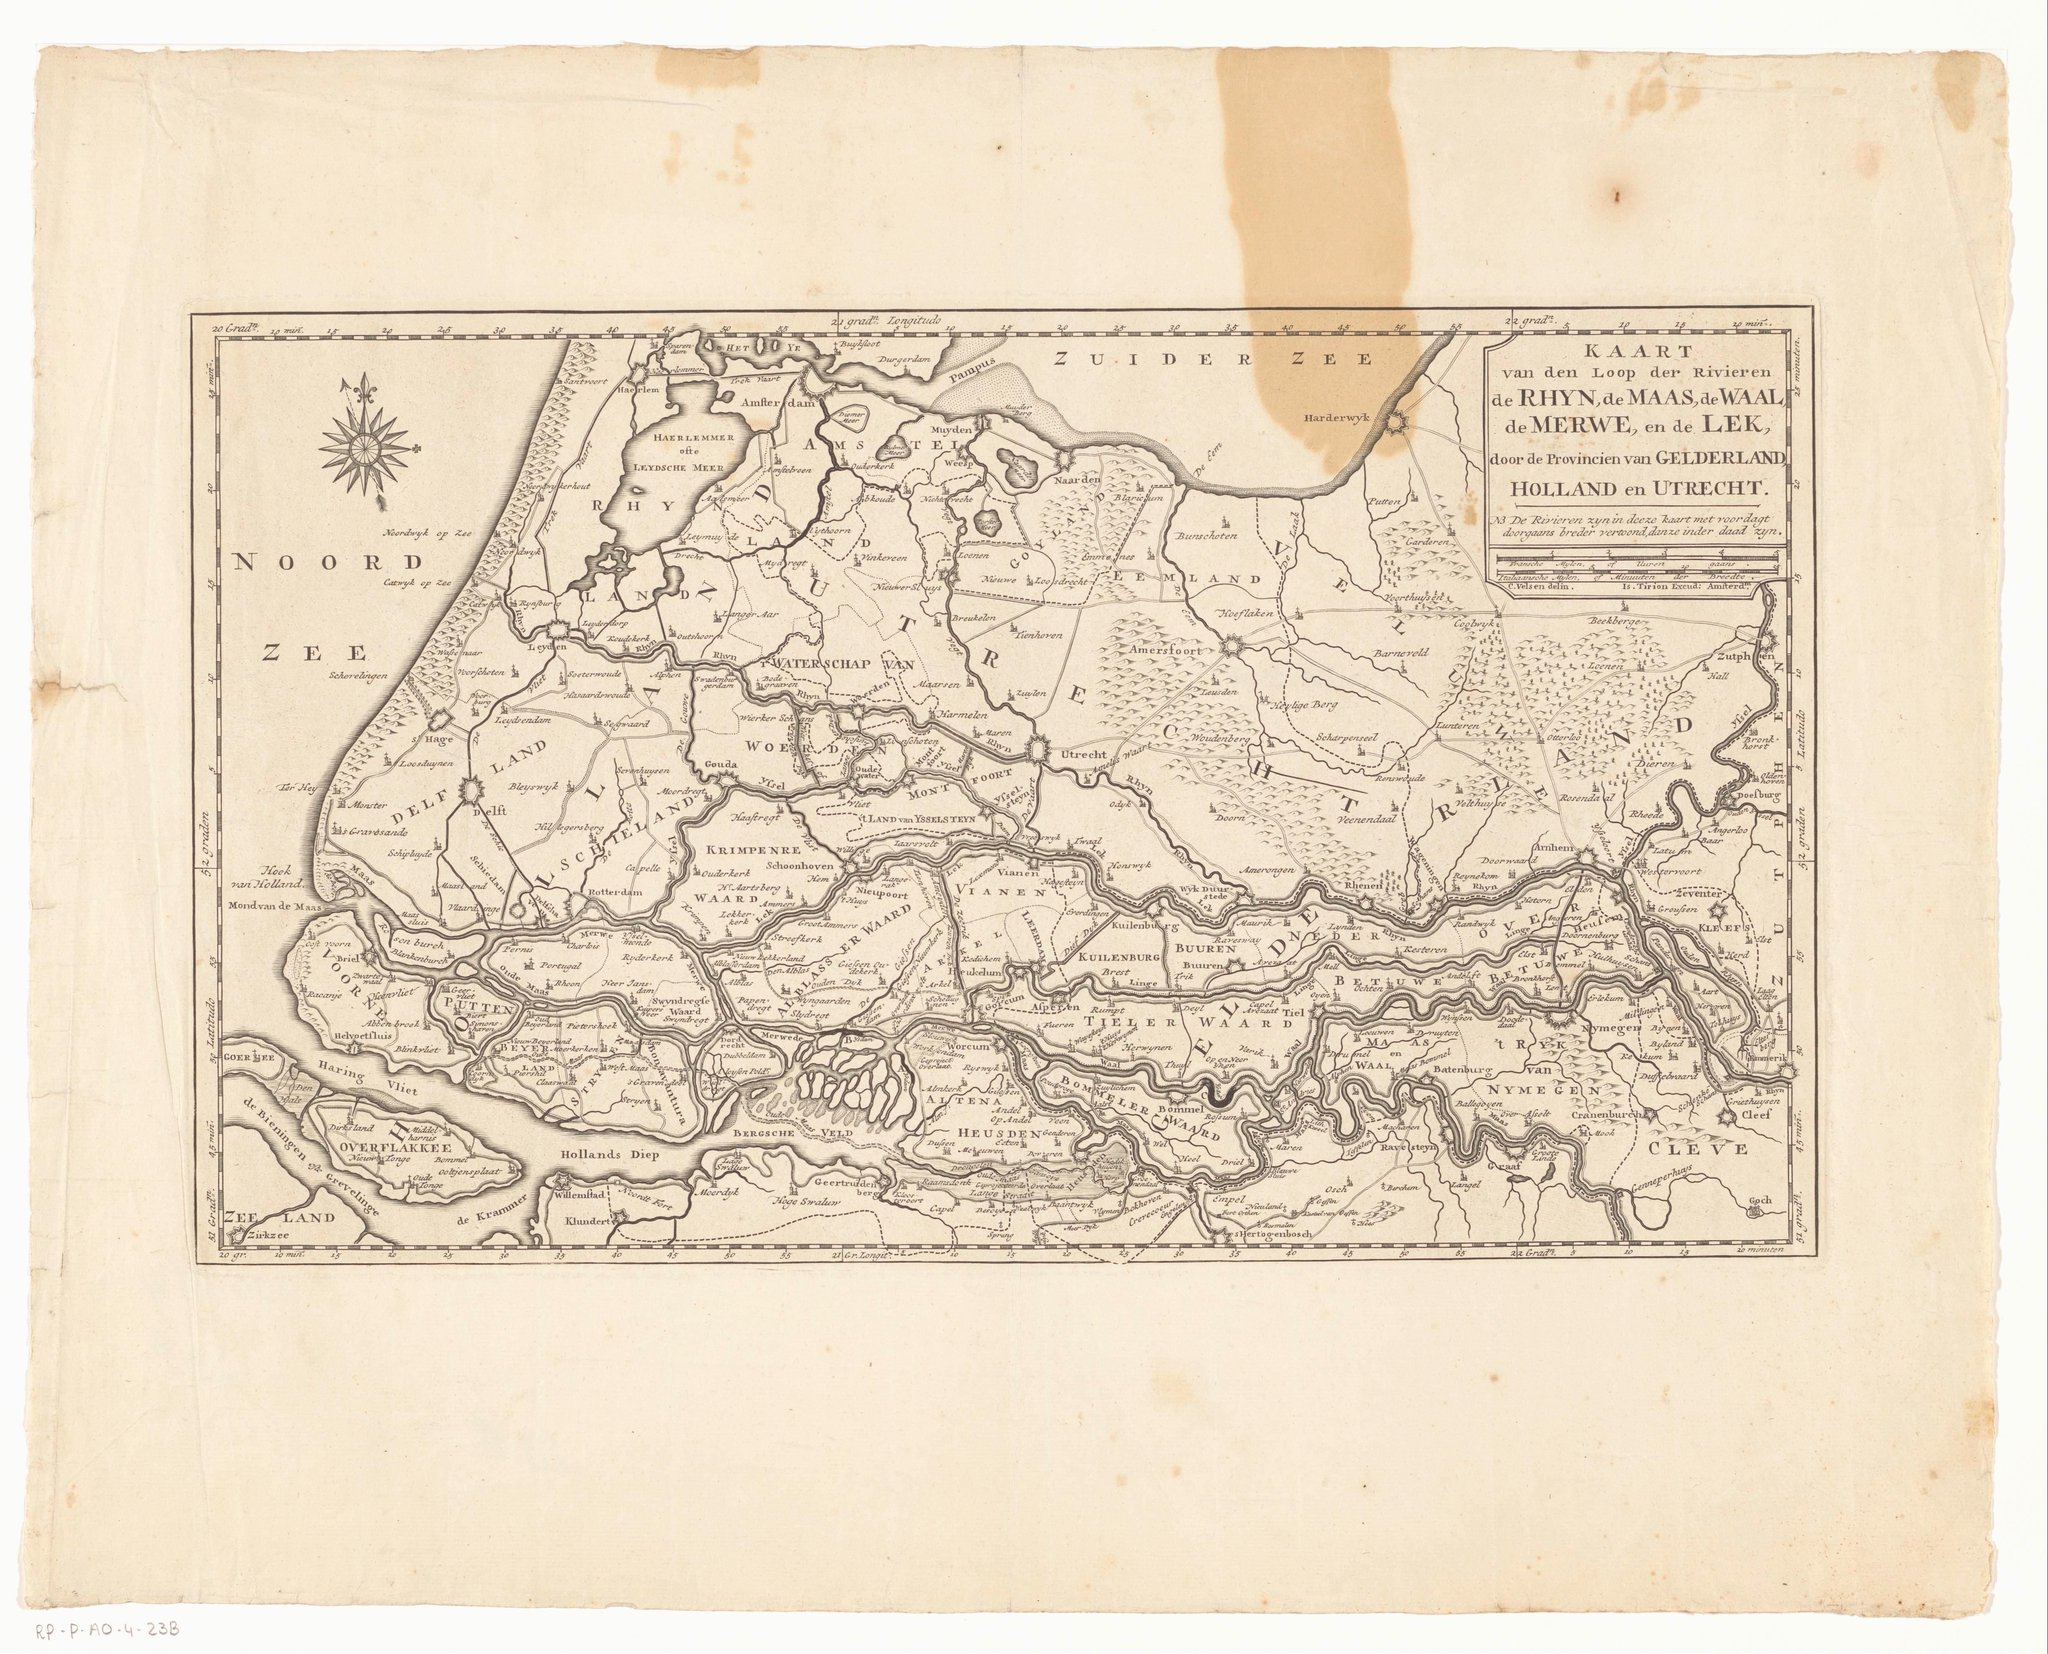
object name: print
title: Kaart van het gebied rond de Rijn, de Maas, de Merwede en de Lek in Gelderland, Holland en Utrecht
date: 1749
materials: paper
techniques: engraving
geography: amsterdam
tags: maps of separate countries or regions, gelderland, holland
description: Prent ook gebruikt in: Velsen, Cornelis. Rivierkundige verhandeling, afgeleid uit waterwigt- en waterbeweegkundige grondbeginstelen, en toepasselyk gemaakt op de rivieren, den Rhyn, de Maas, de Waal, de Merwede, en de Lek (…). Amsterdam: Isaac Tirion, 1749.